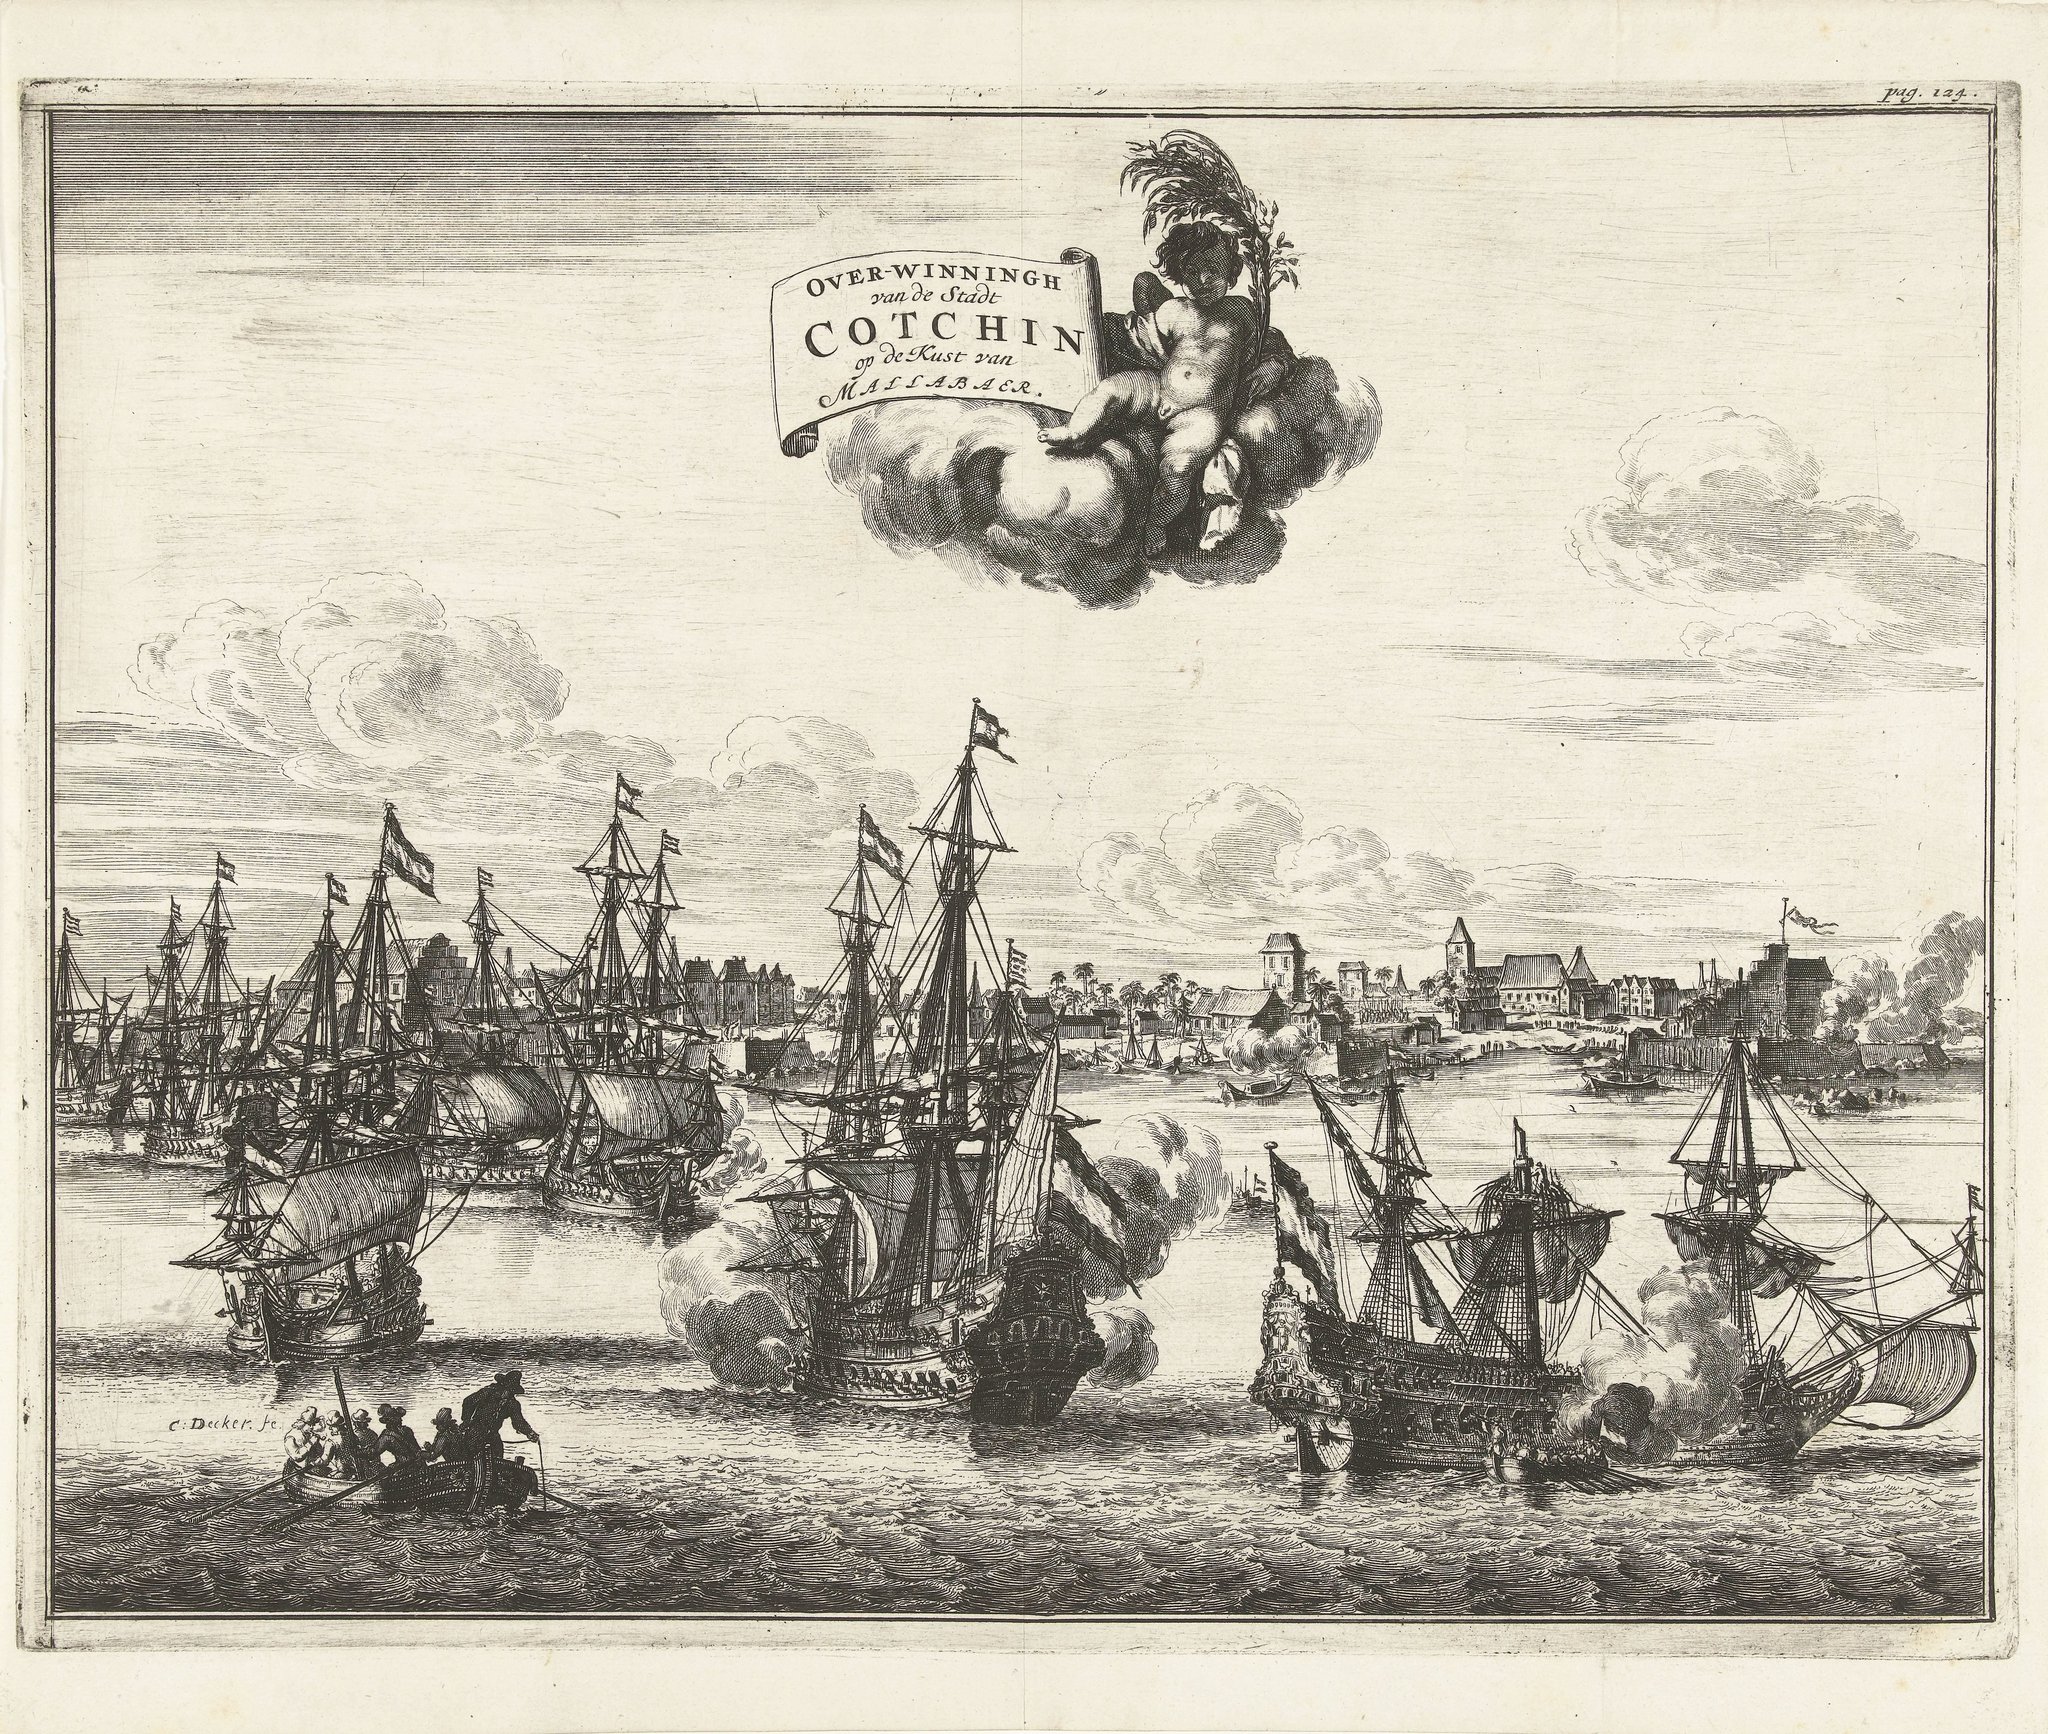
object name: book illustration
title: Inname van Cochin door Nederlandse V.O.C. schepen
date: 1682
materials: paper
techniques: etching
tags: battle (+ sailing-ships)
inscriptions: collector's mark: Lugt 2228, collector's mark: Lugt 2760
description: Inname van Cochin op de Portugezen door Nederlandse V.O.C. schepen voor de kust van Malabar in India. De schepen vuren met kanonnen op de nauwelijks versterkte kustplaats. In de lucht kleine engel op wolk met banderol met titel.